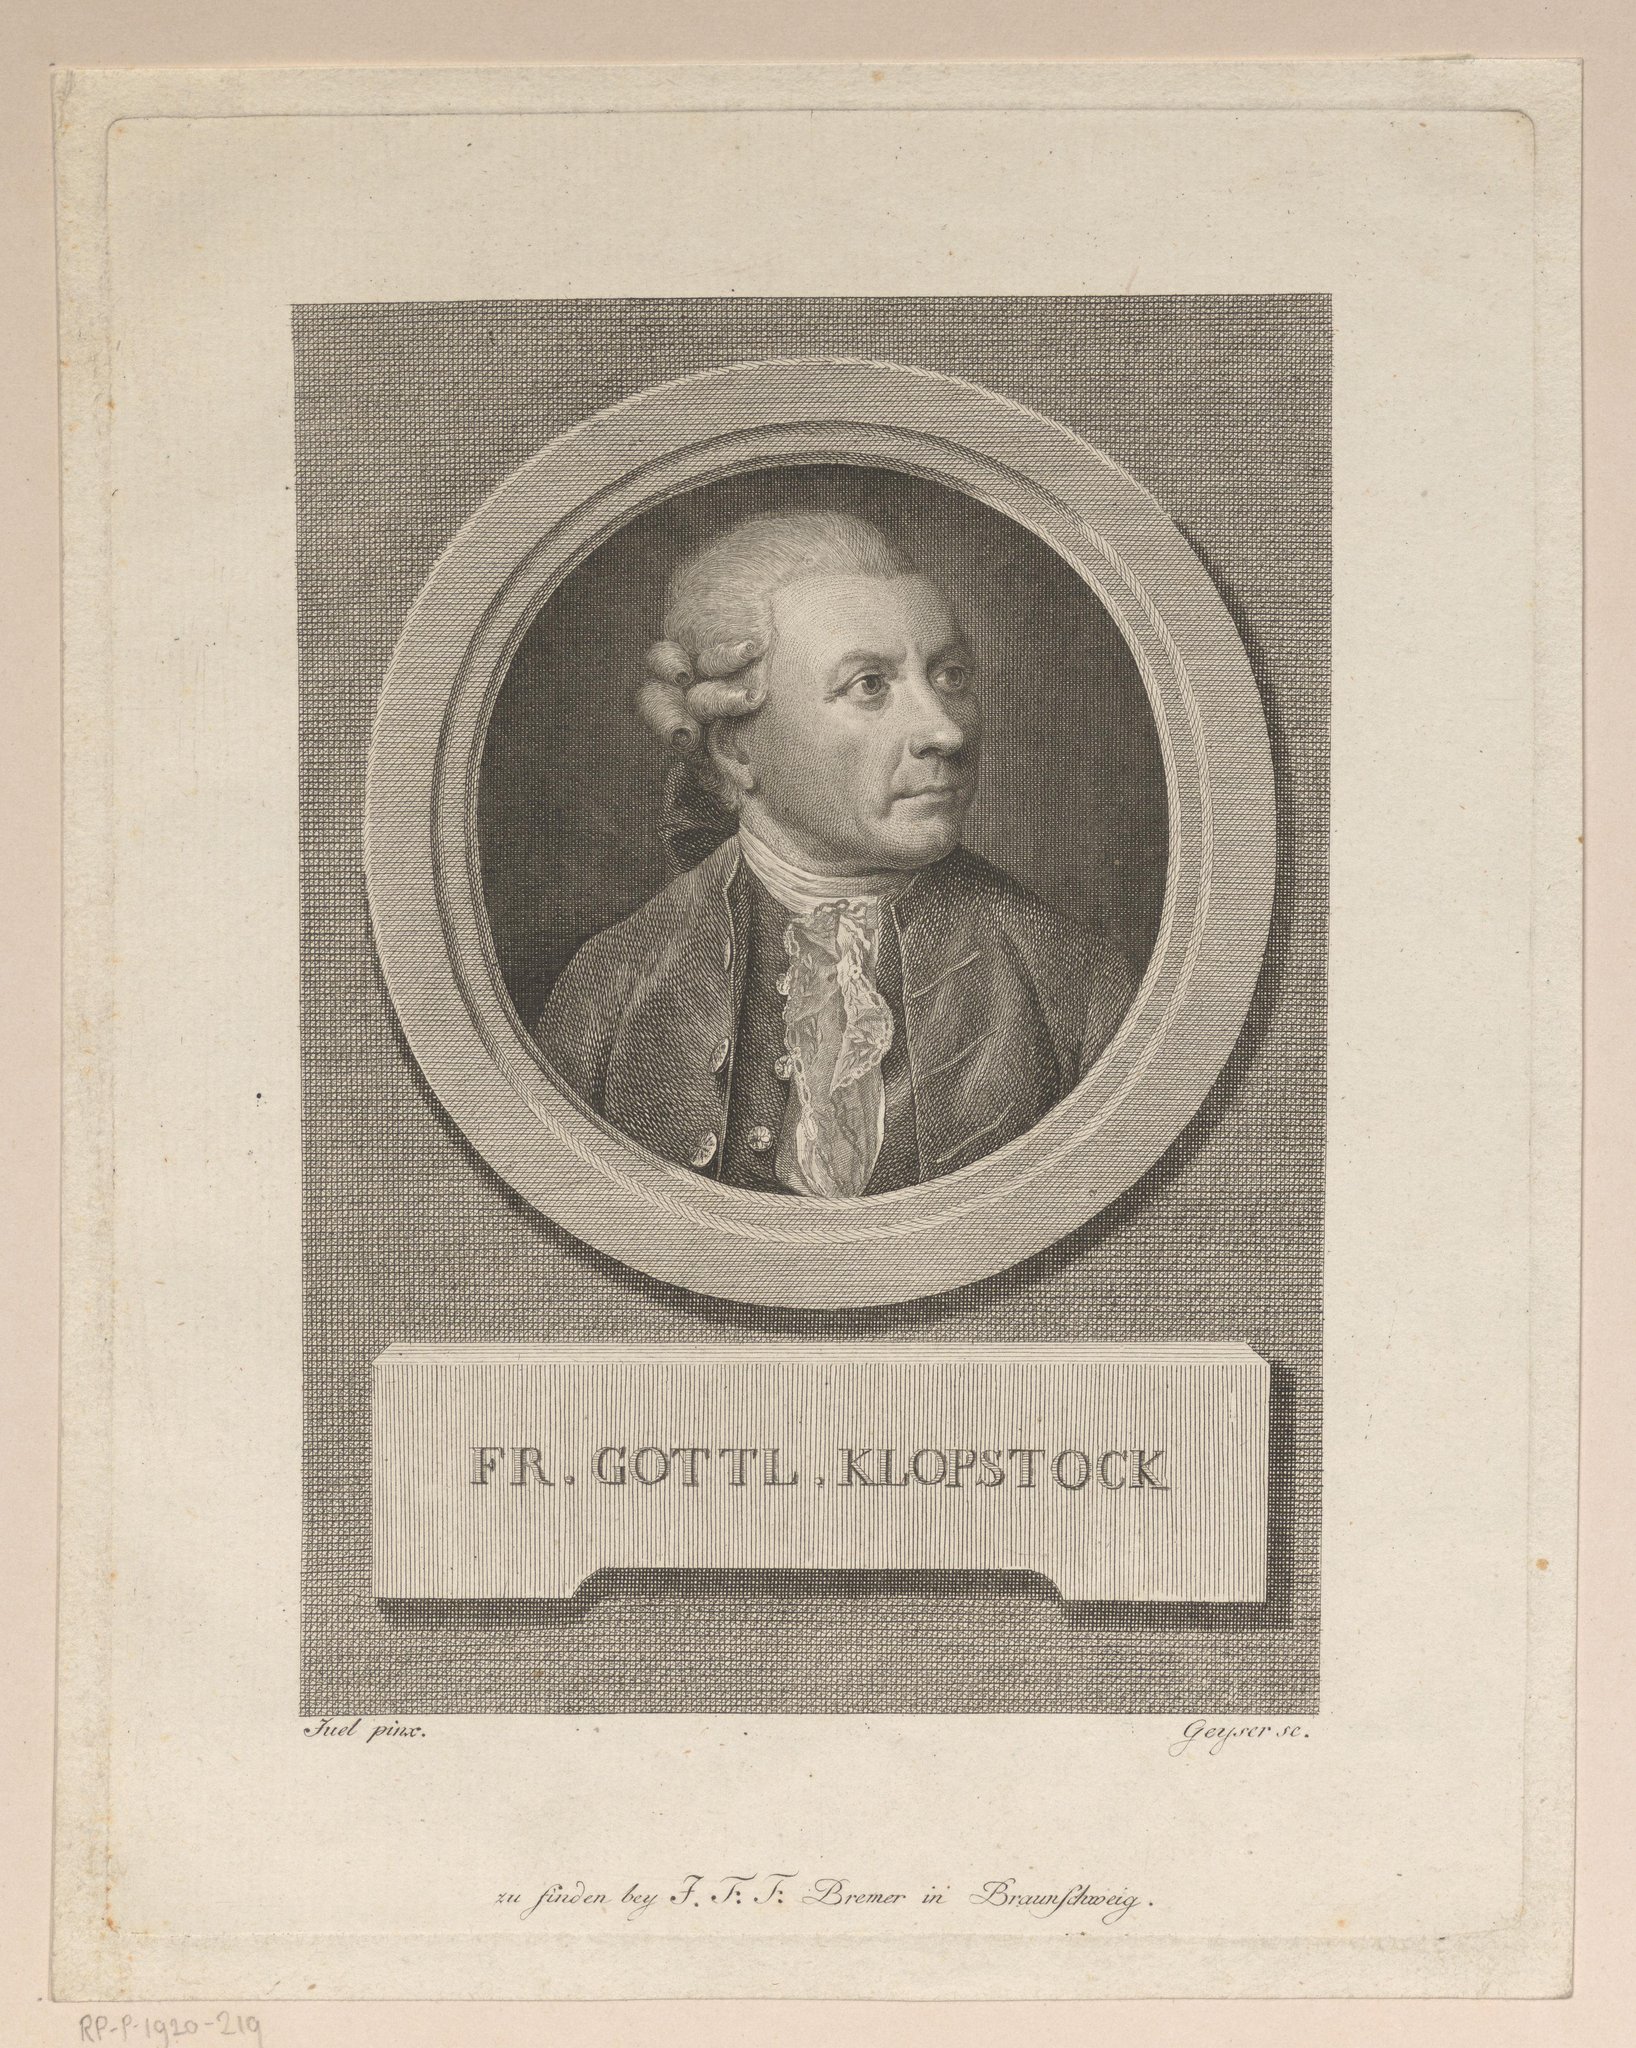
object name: print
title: Portret van Friedrich Gottlieb Klopstock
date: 1779-1803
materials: paper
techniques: engraving, etching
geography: braunschweig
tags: historical persons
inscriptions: collector's mark: Lugt 2228